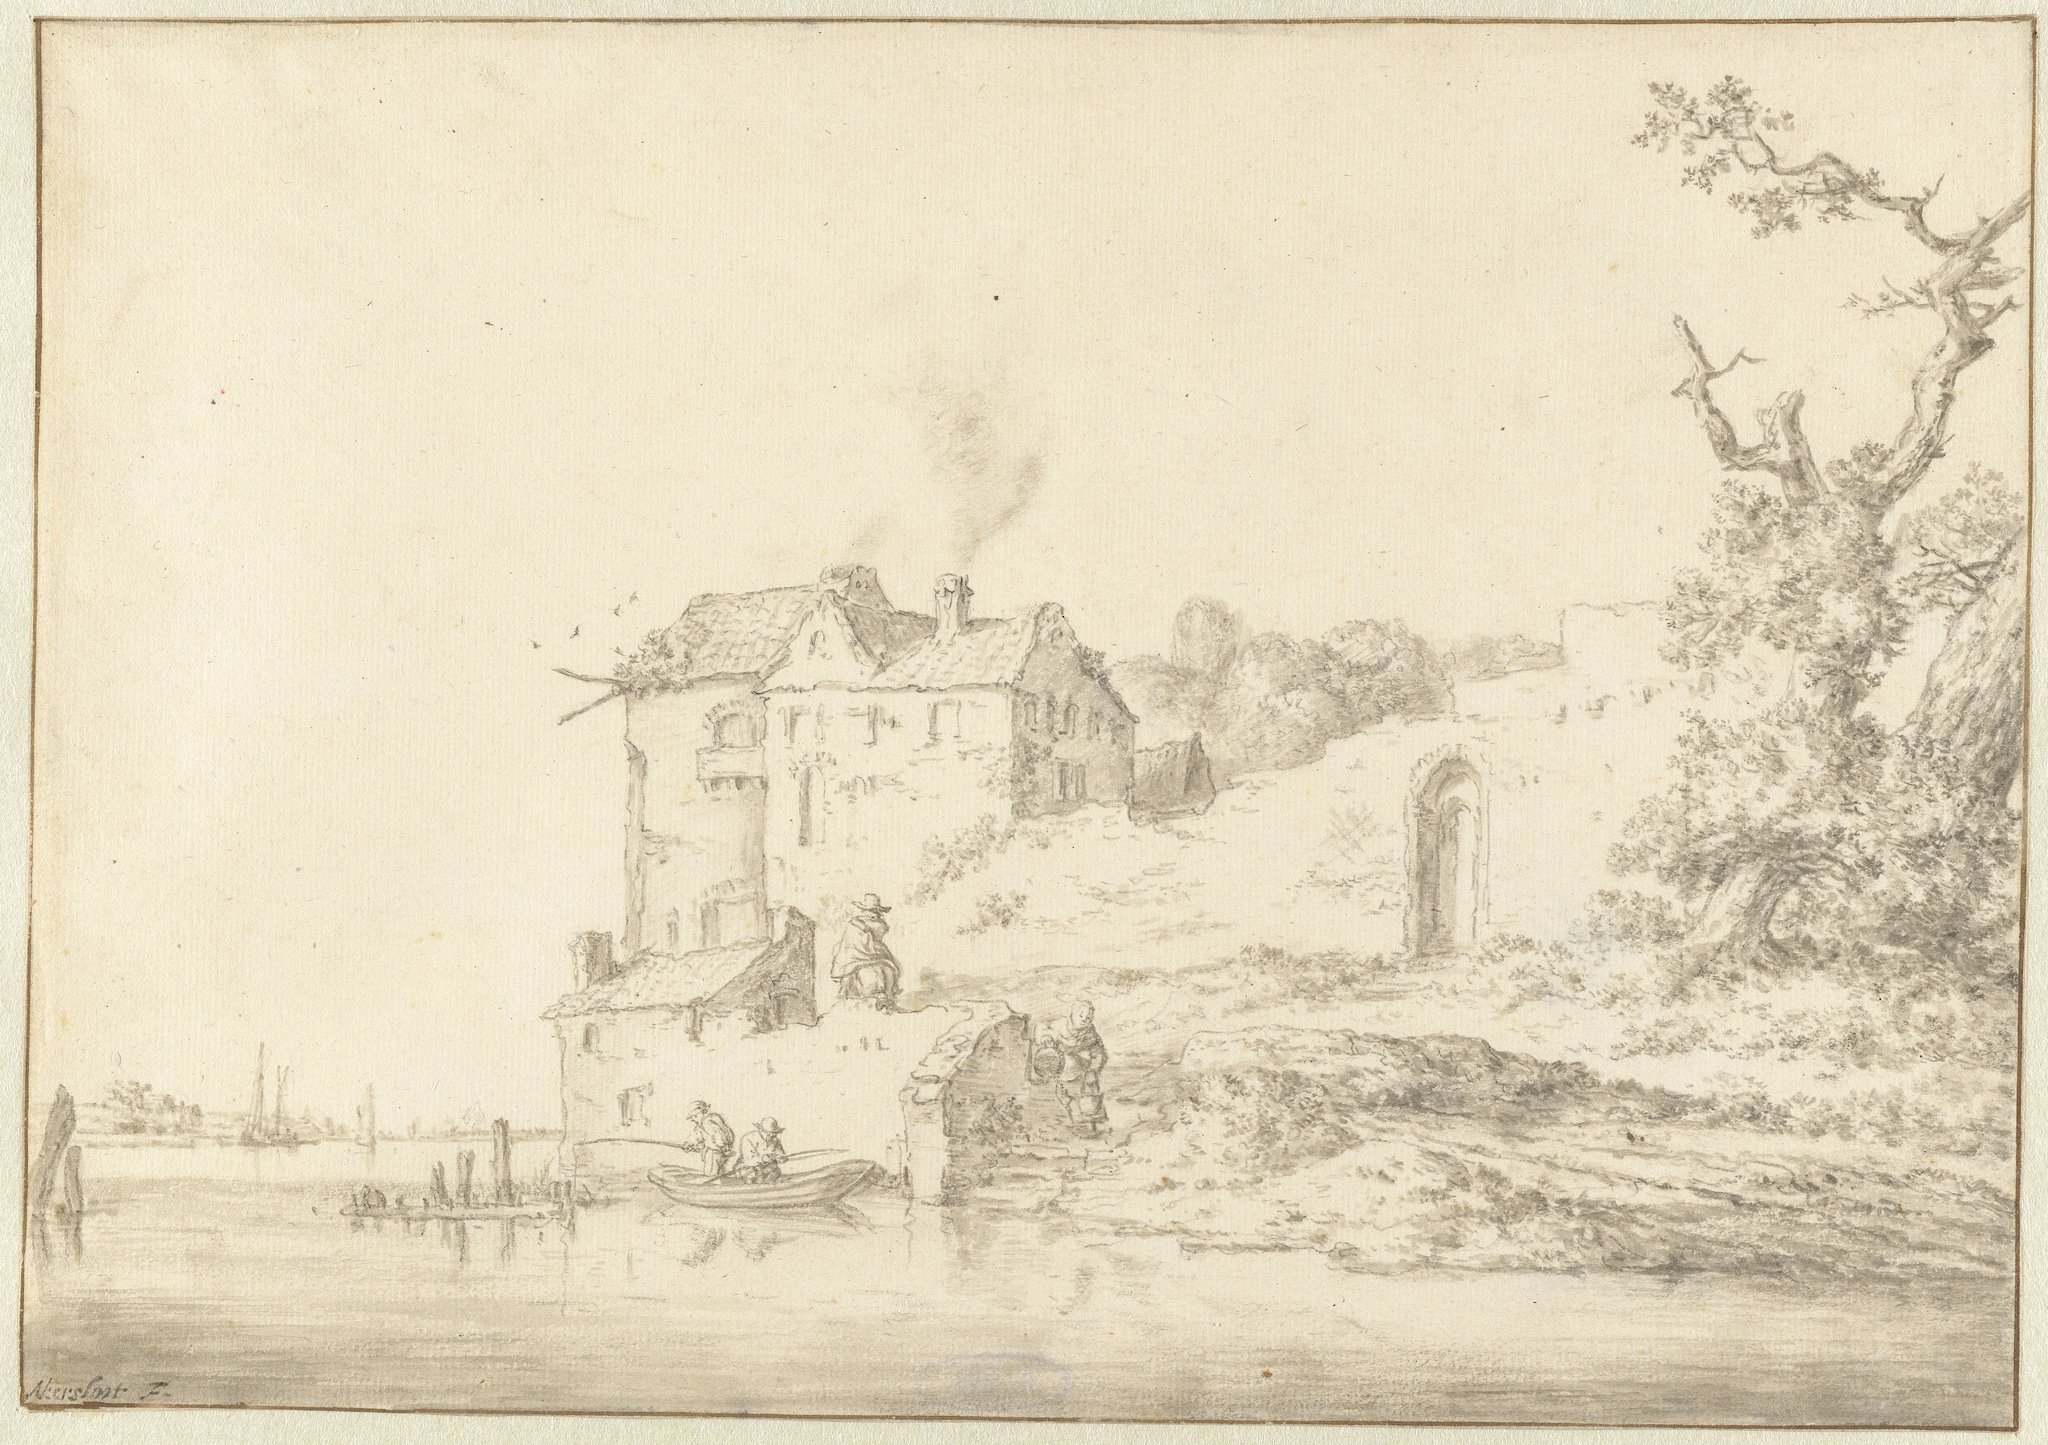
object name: drawing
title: Landschap met vervallen huis aan een rivier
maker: jacob akersloot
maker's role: draughtsman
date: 1684-1724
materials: chalk, graphite, ink, paper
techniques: brush, pen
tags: landscape with ruins, city-walls, river (+ landscape with figures, staffage), civic architecture; edifices; dwellings